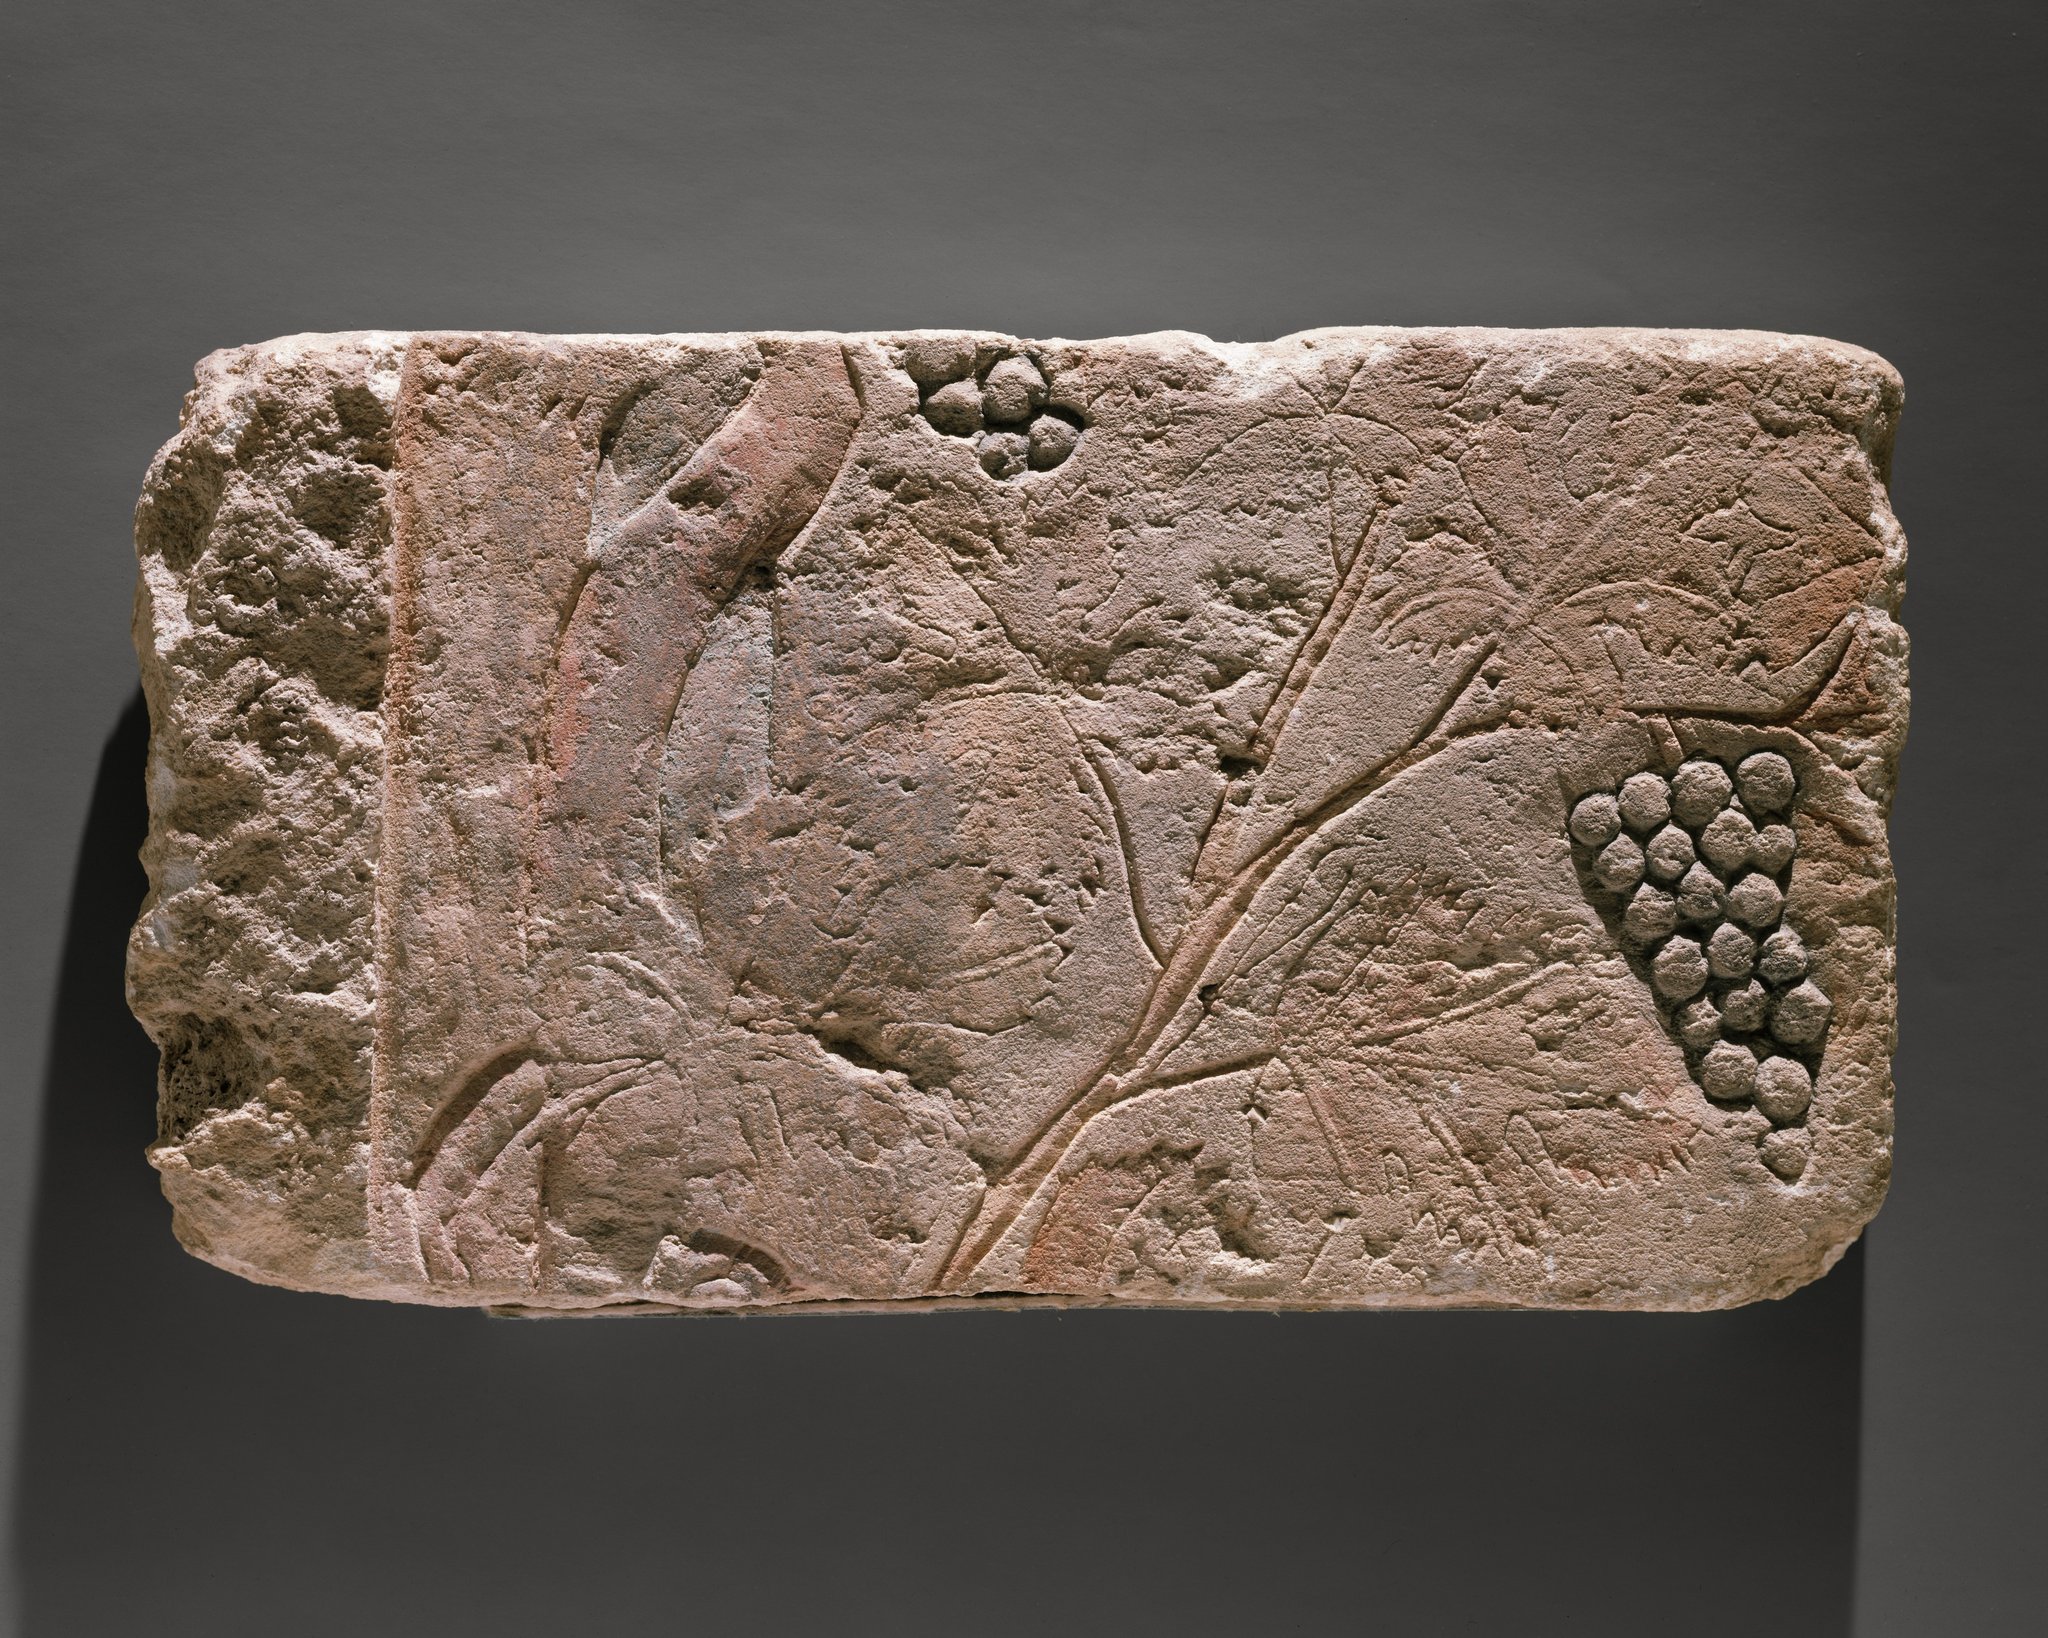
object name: talatat, grapevine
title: Grapevine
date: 1353-1336 BCE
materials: limestone, paint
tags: grapes,vines